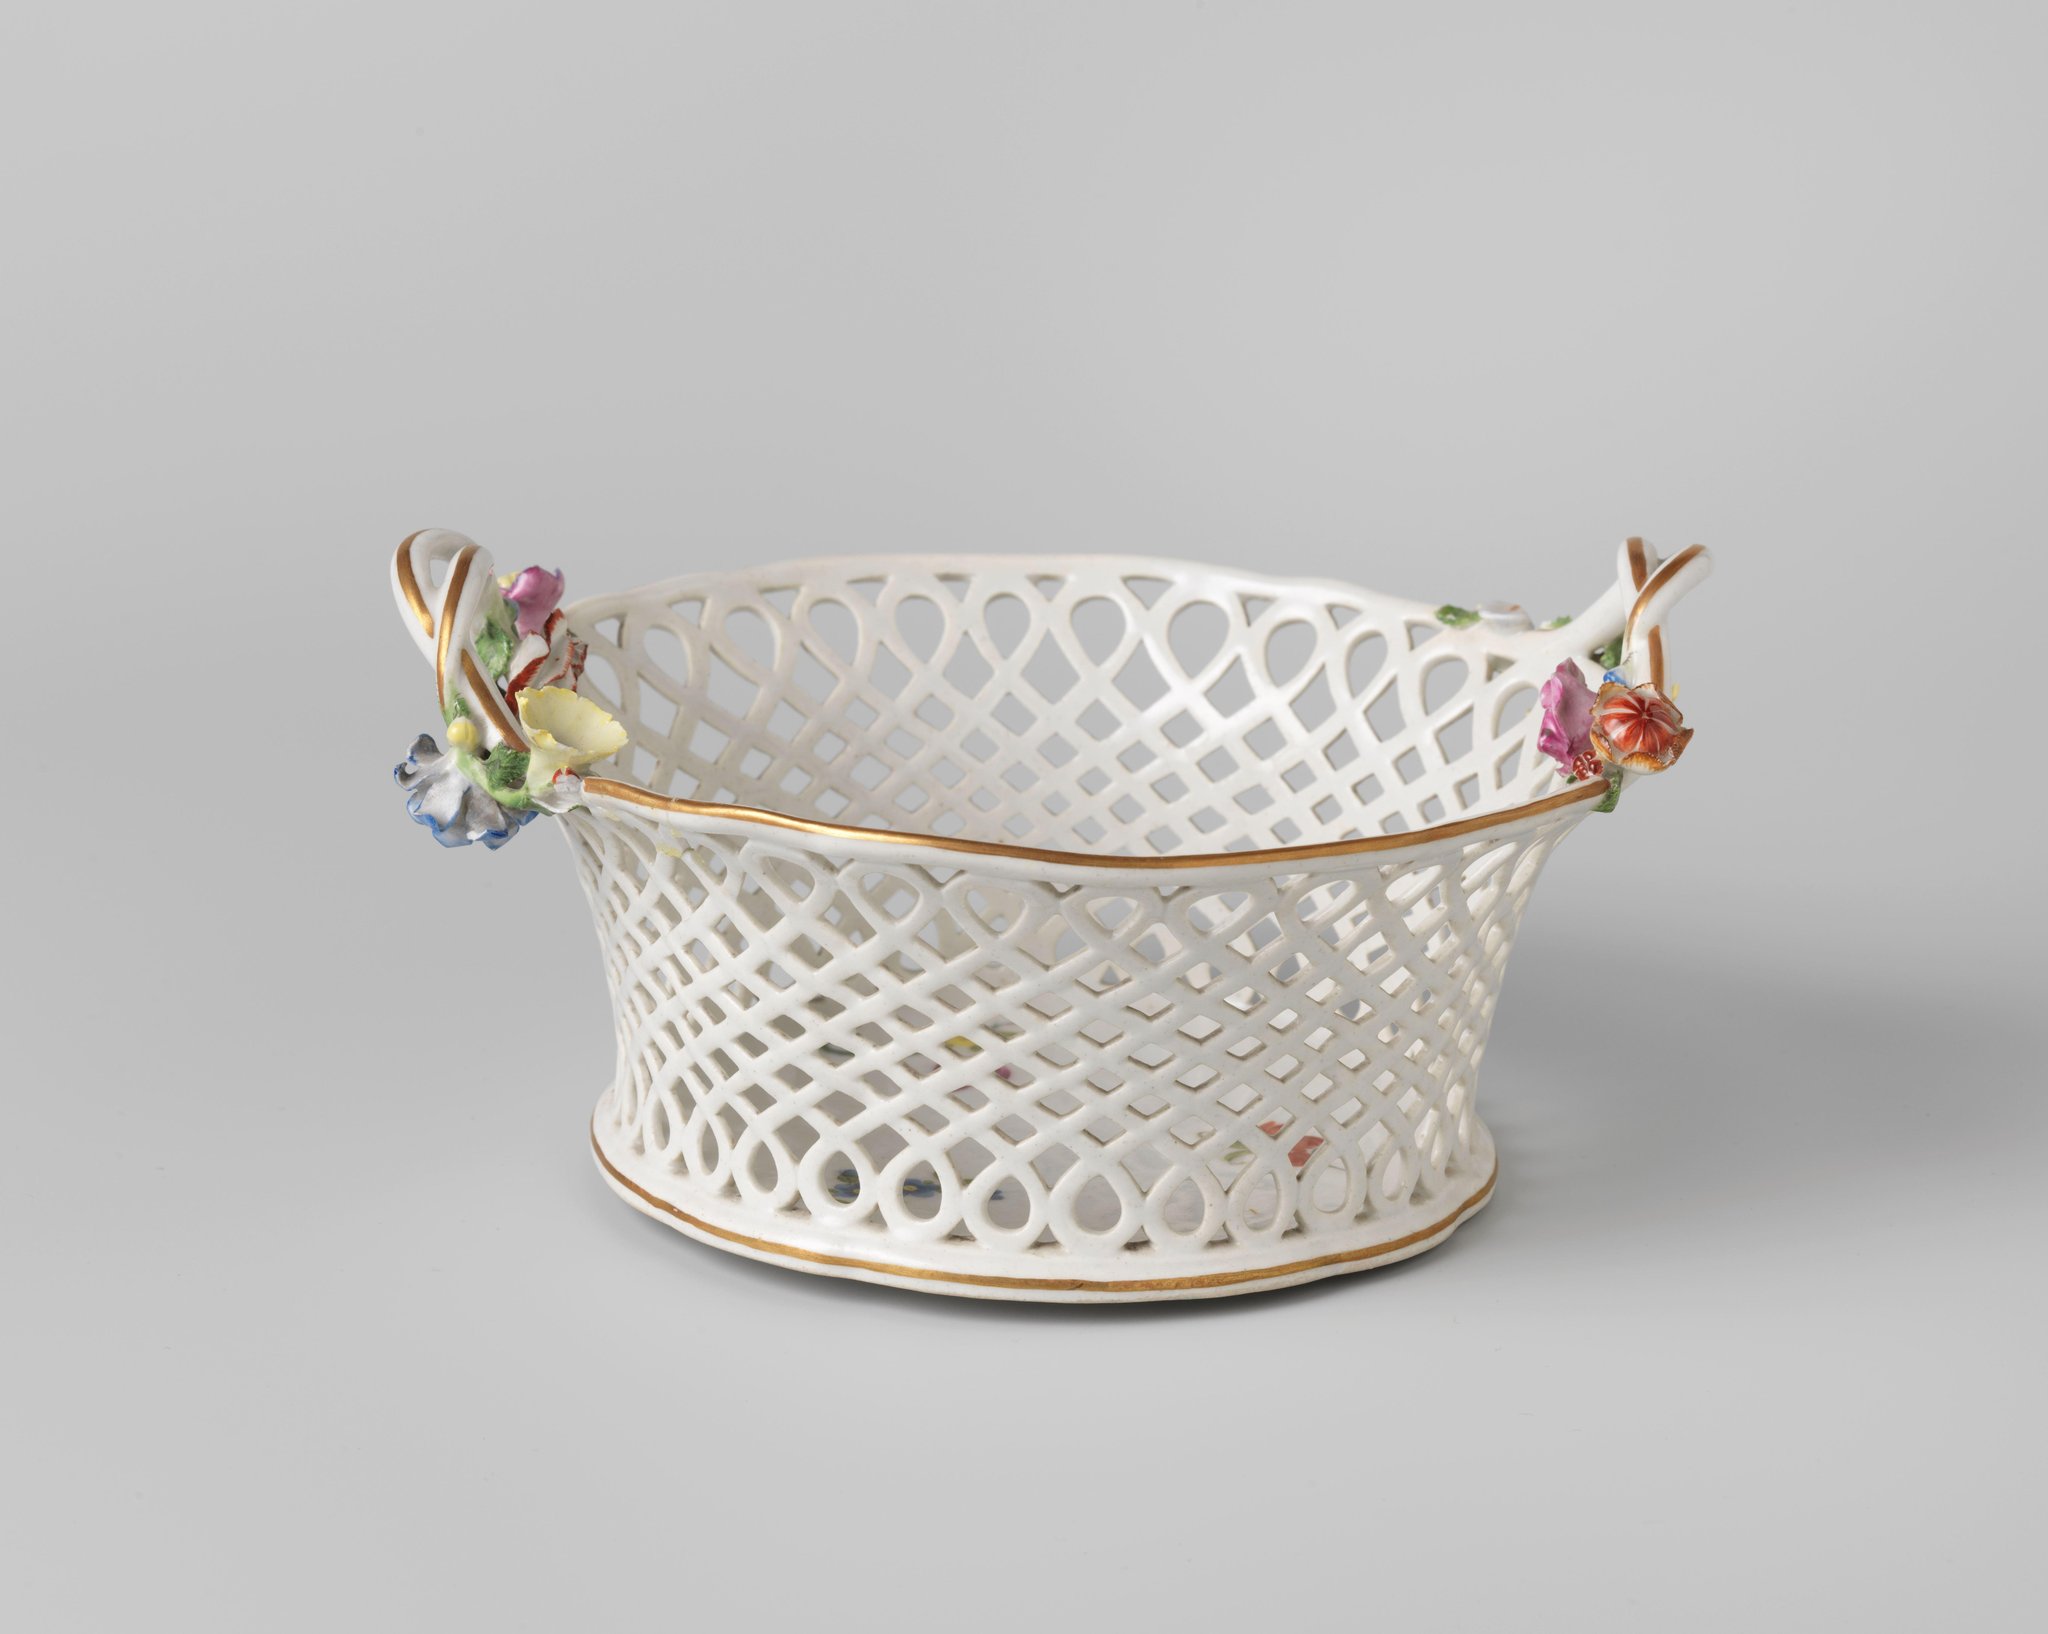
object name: fruit basket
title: Fruitmand van porselein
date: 1774-1784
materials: porcelain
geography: loosdrecht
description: Ronde, witte fruitmand van porselein. Geheel opengewerkt. Rond de oren veelkleurige versieringen. Langs de randen gouden biezen. Op de bodem zijn veelkleurige bloemboeketten geschilderd.